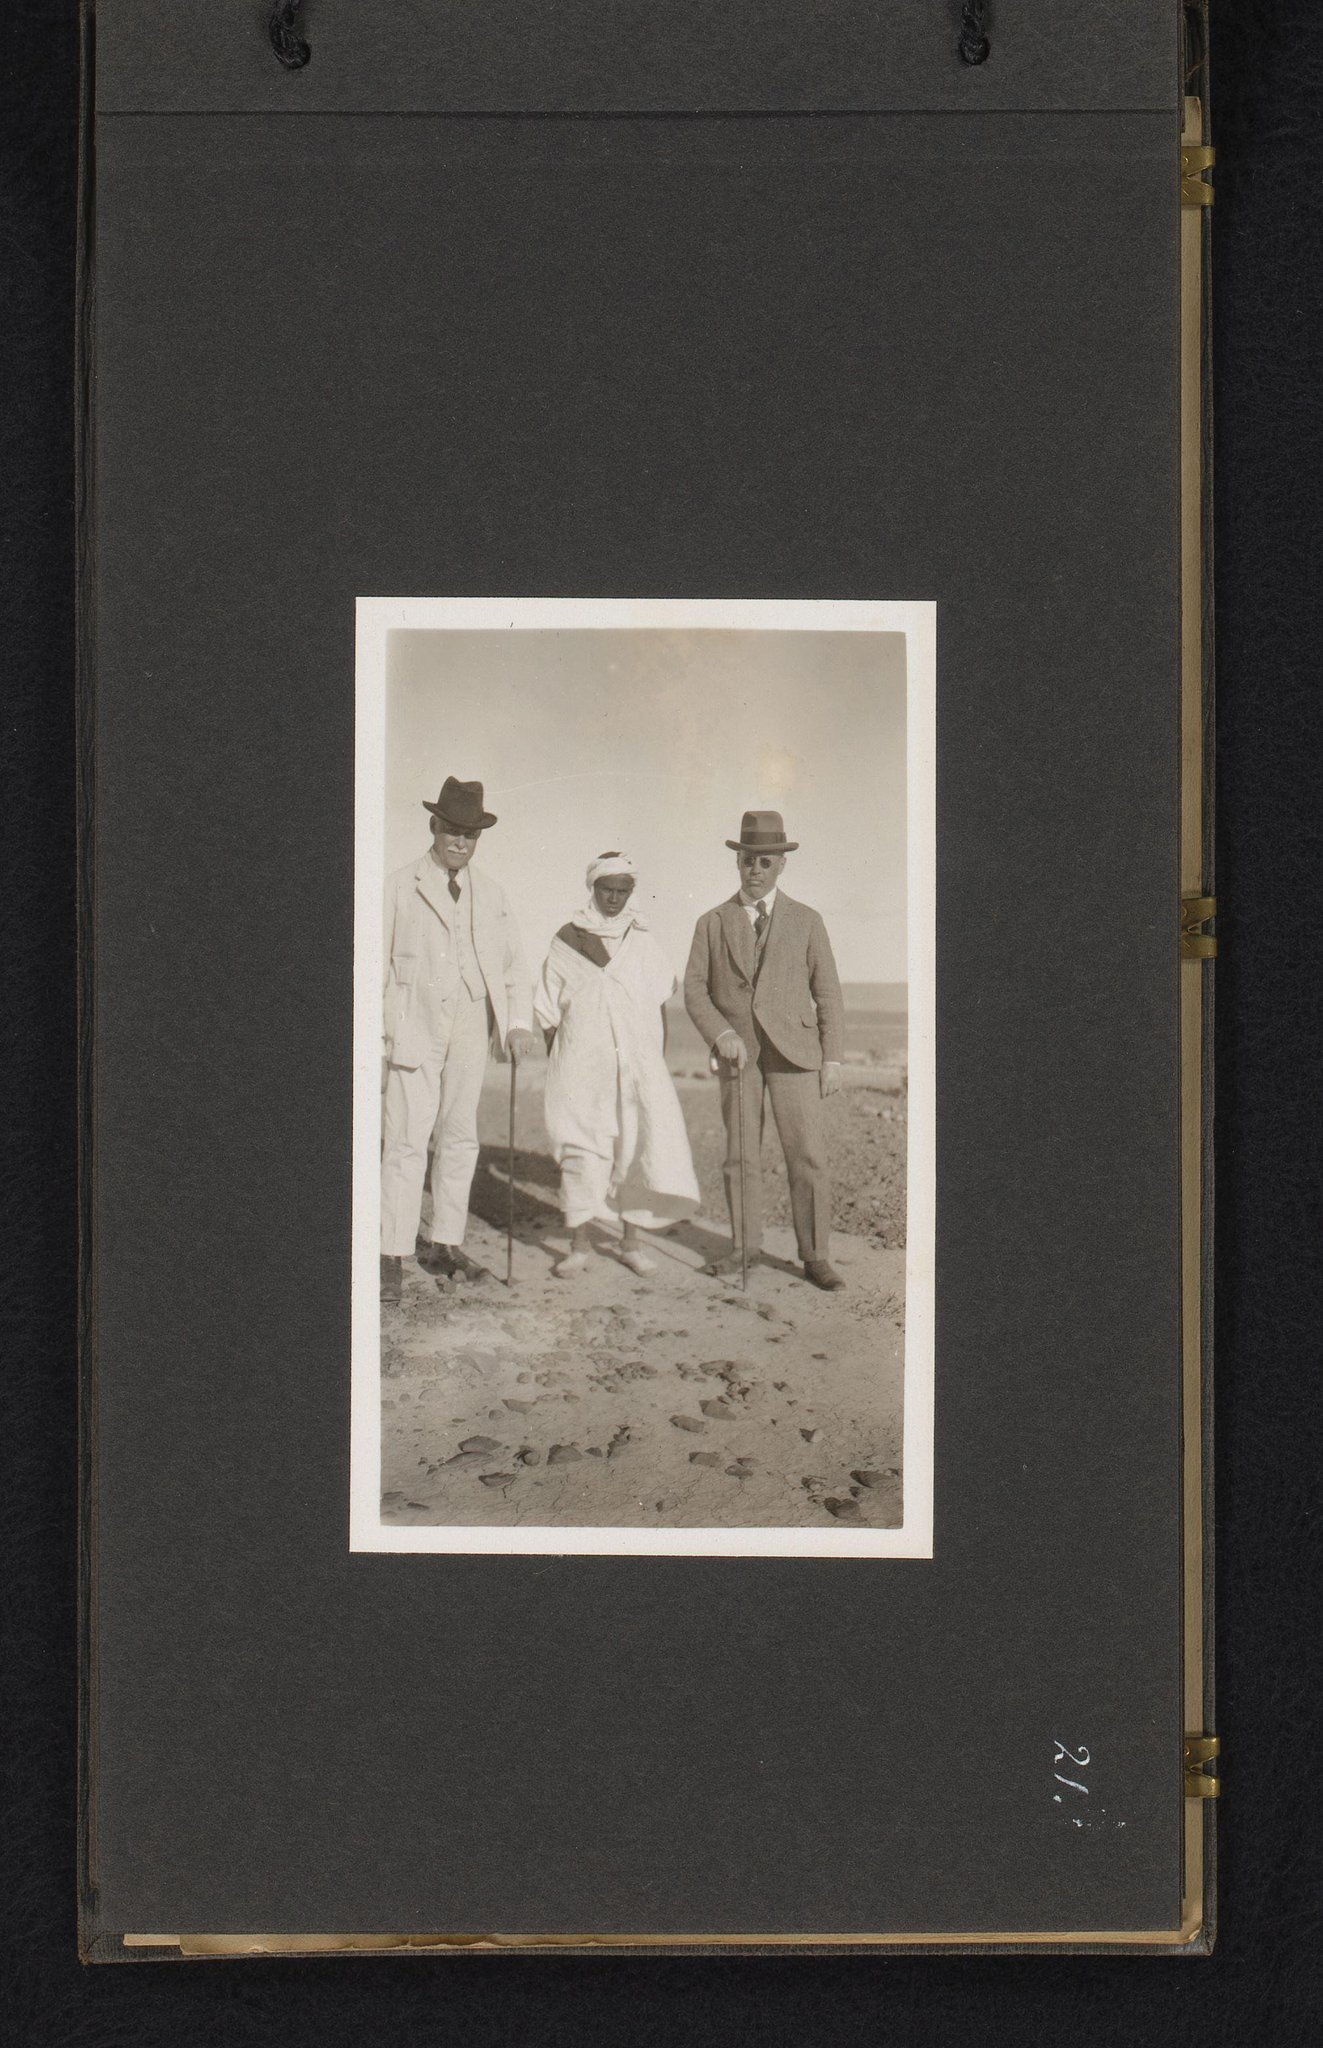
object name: album leaf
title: Twee Europese mannen en een Algerijnse man in de woestijn van Béni Ounif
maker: a.g.a. van eelde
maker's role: engineer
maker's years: 1862-1950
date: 1927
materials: paper, photographic support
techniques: gelatin silver print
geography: algeria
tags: adult man, historical persons, desert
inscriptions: number: ‘21.’